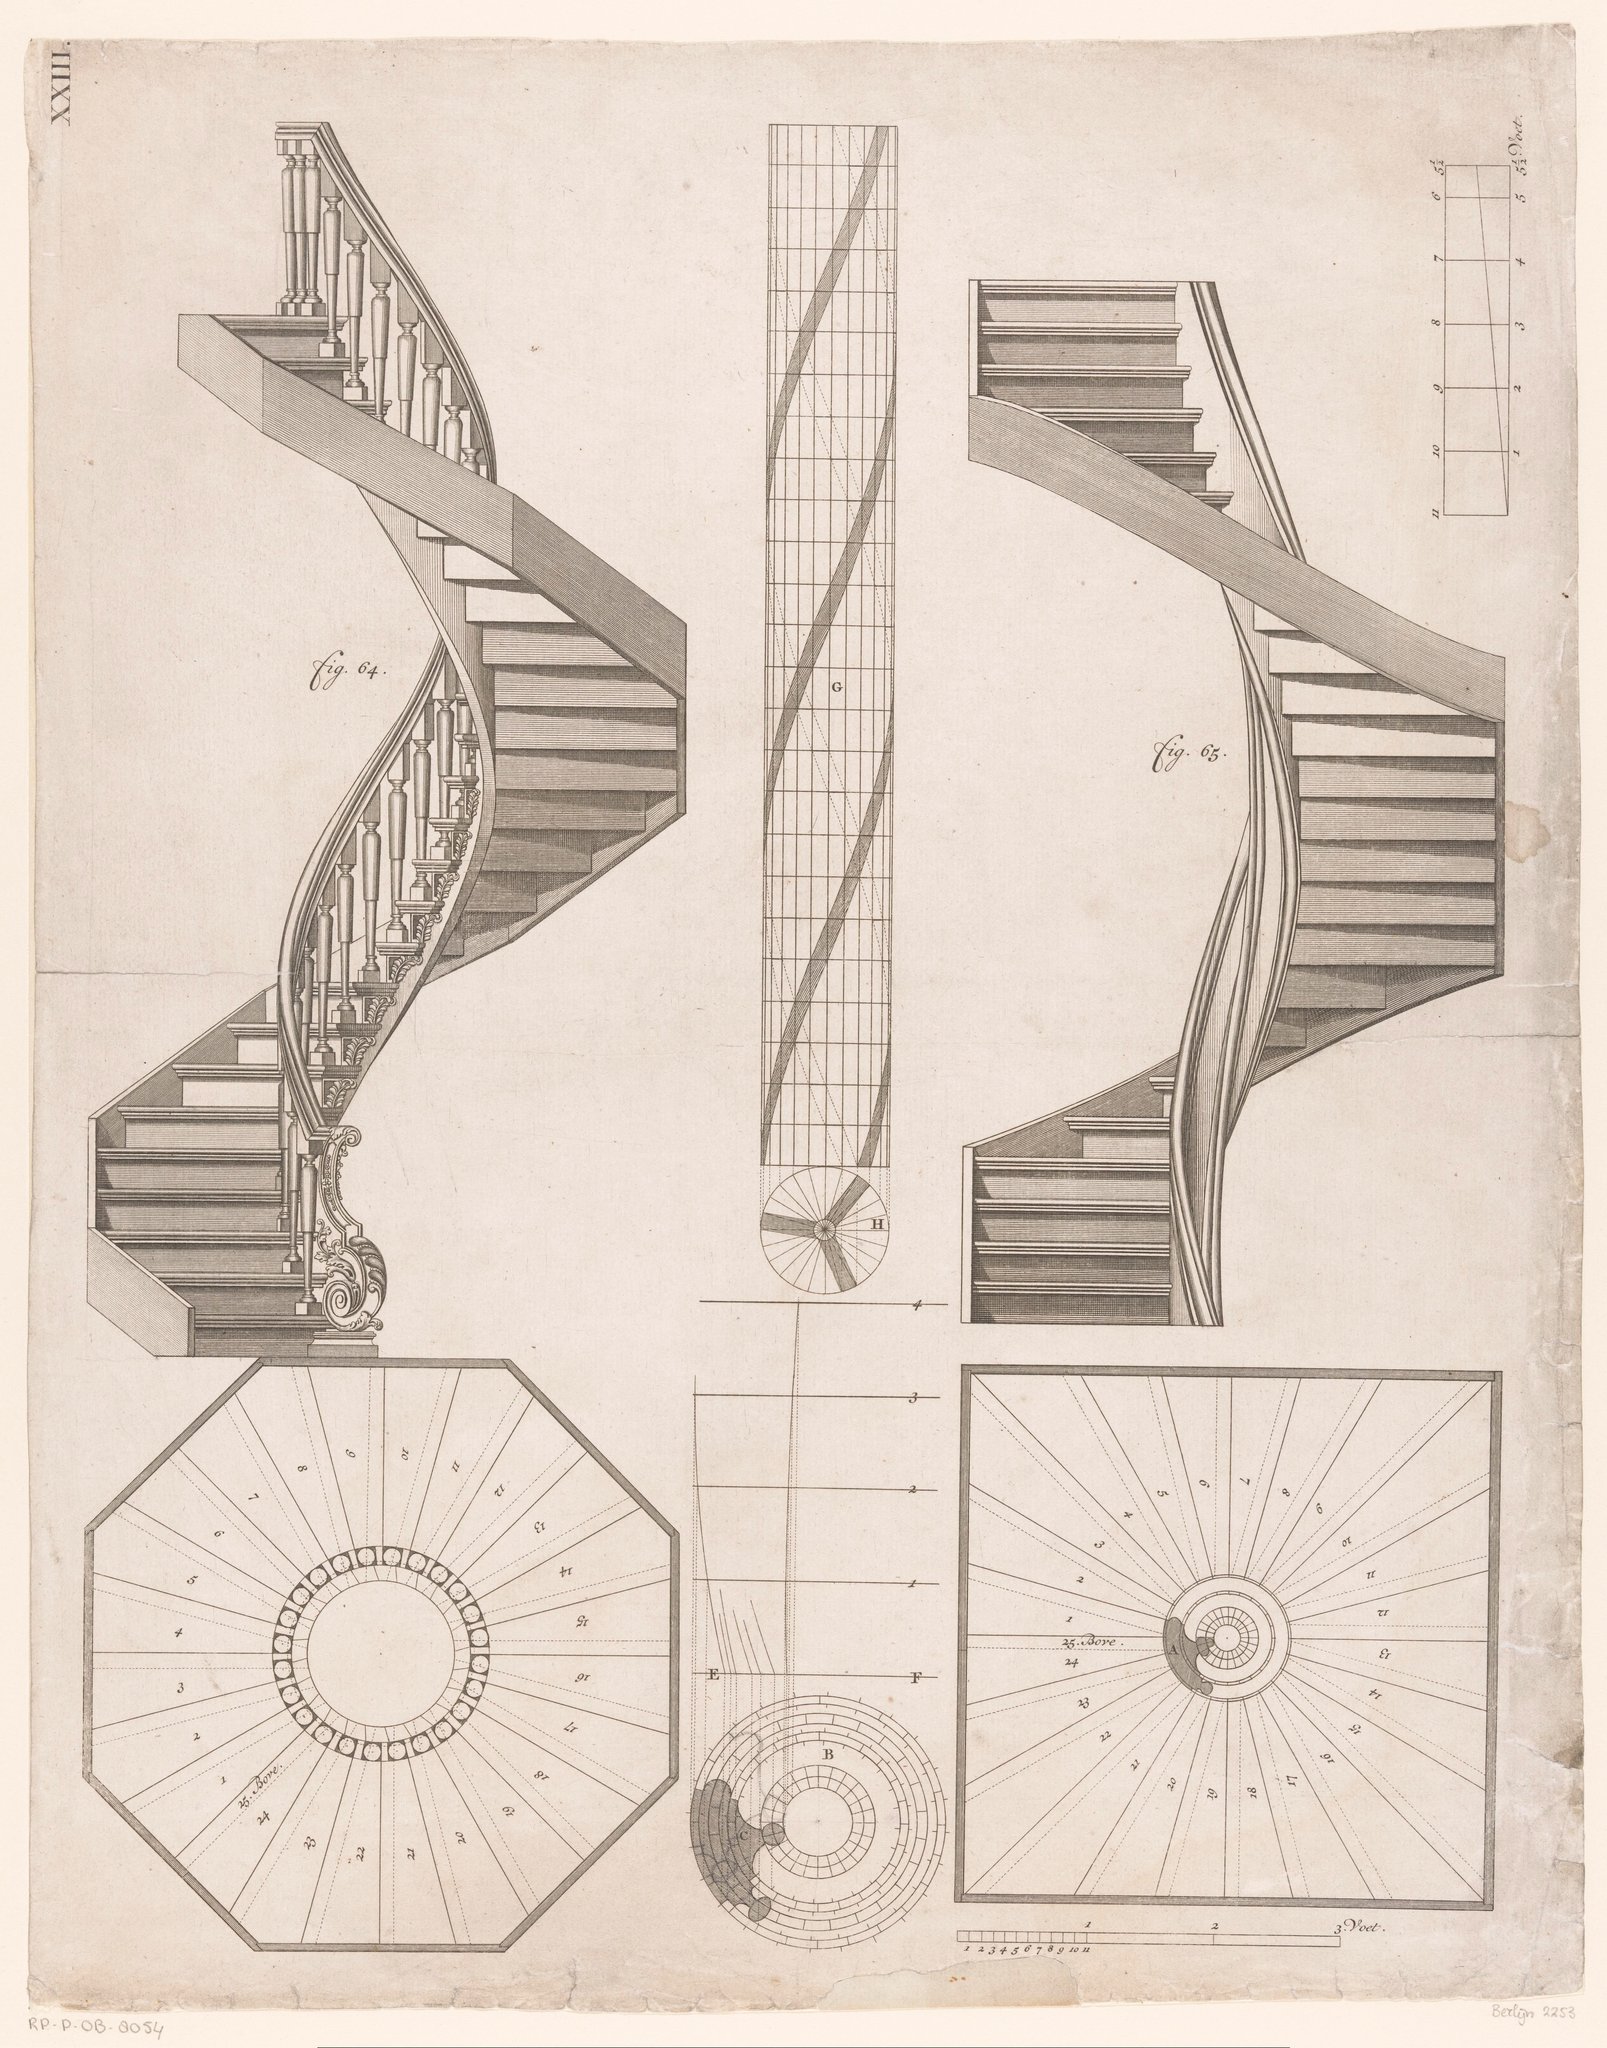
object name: print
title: Theatrum Machinarum Universale; Of Nieuwe Algemeende Bouwkunde (...)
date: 1739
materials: paper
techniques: engraving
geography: amsterdam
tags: drawing (mathematics), staircase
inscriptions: collector's mark: Lugt 2228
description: Technische tekeningen van wenteltrappen (nummers 64 en 65). Boven- en zijaanzichten.